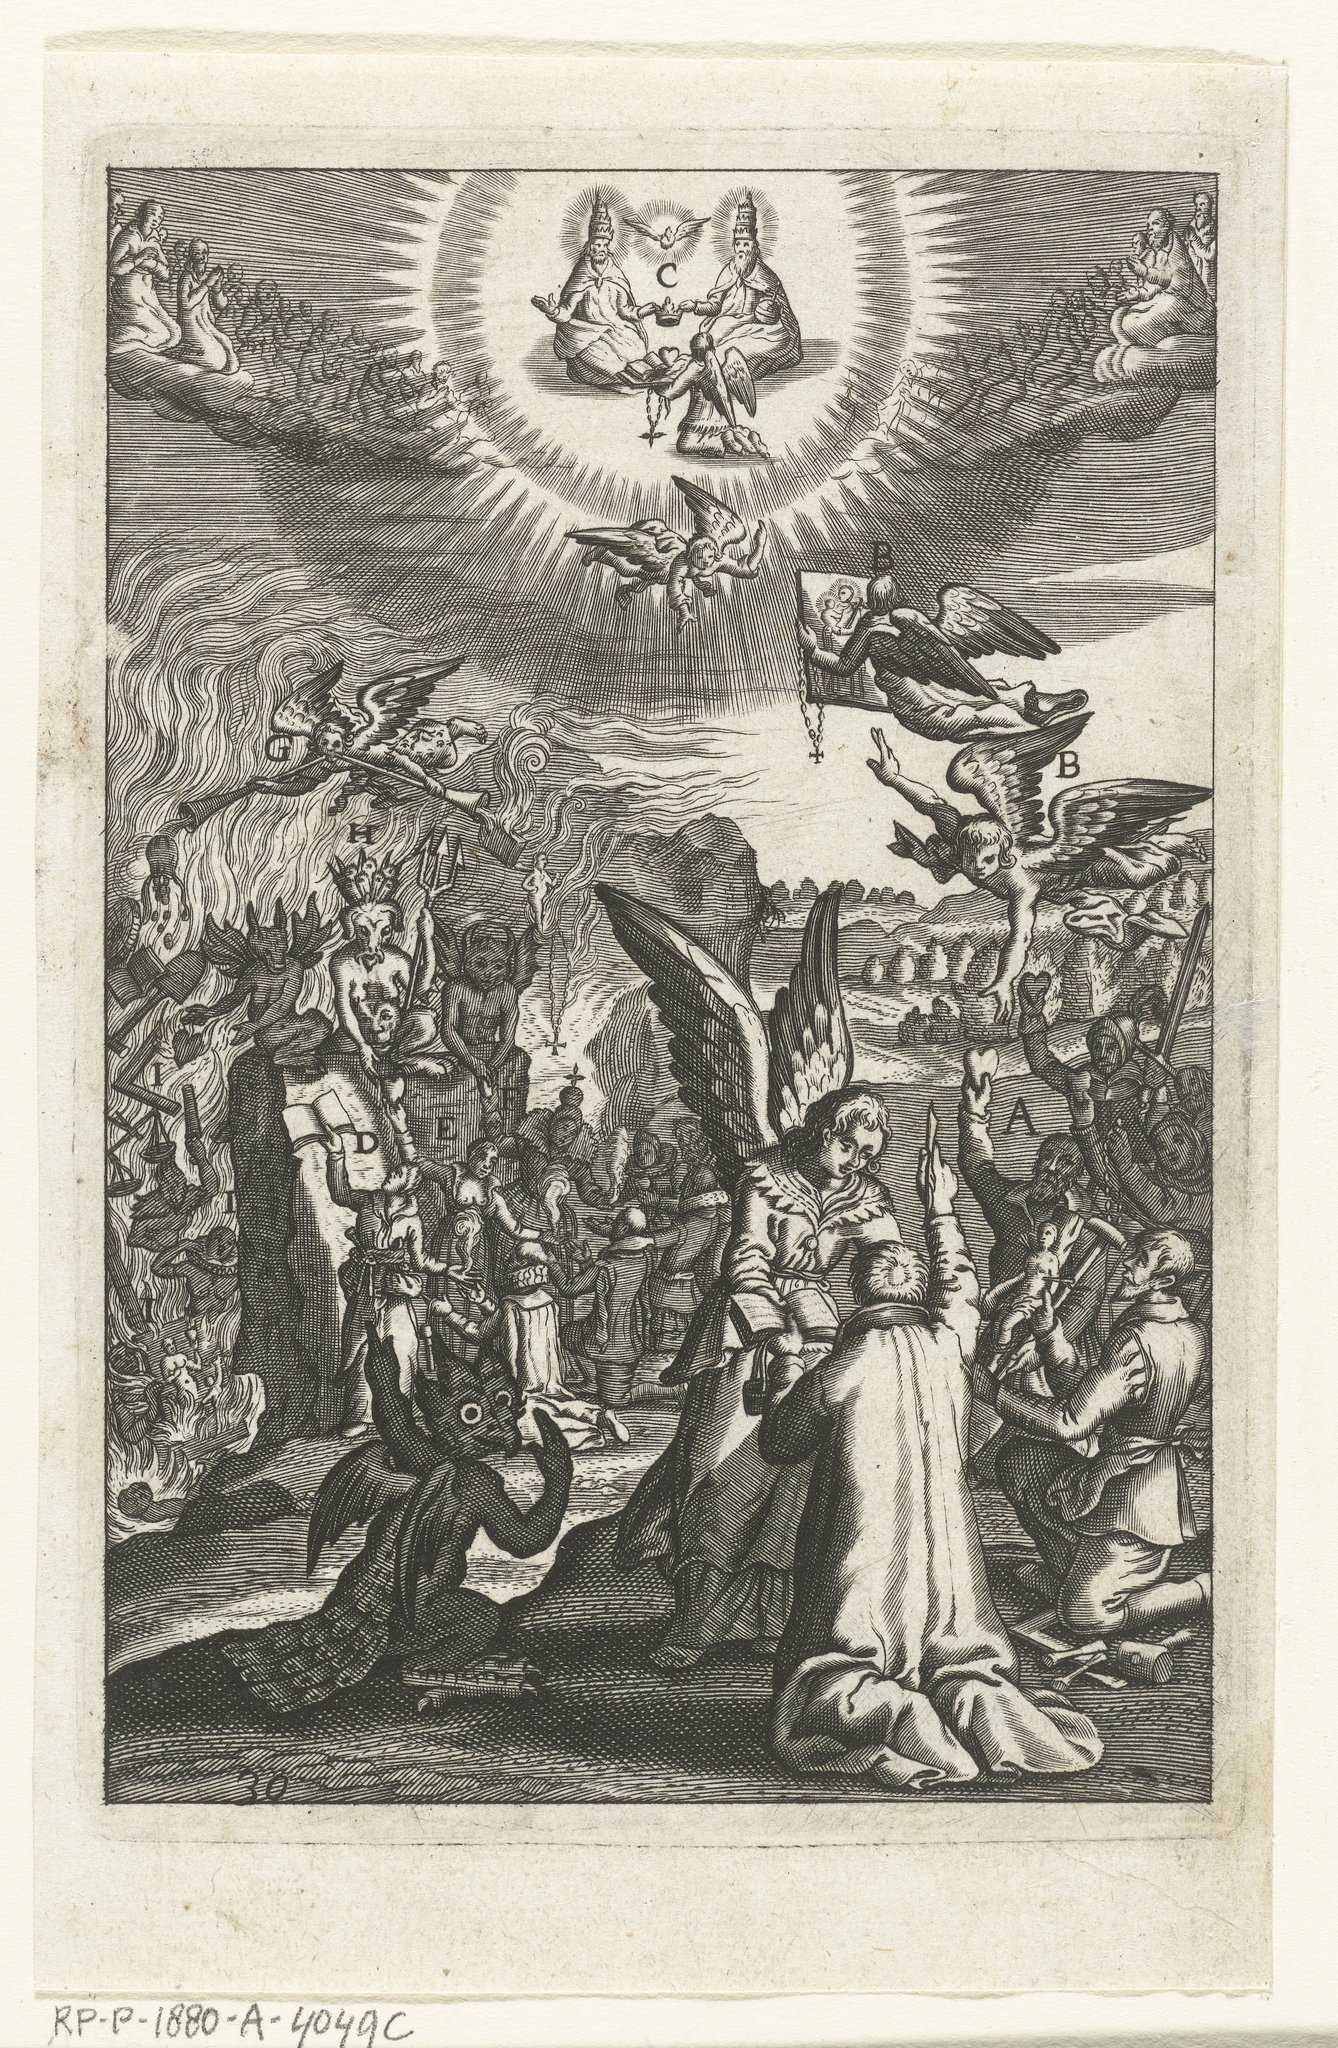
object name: book illustration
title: Den wech des eeuwich levens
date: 1620-1623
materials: paper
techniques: engraving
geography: antwerp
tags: the life of man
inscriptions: collector's mark: Lugt 2228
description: Prent uit: Antoine Sucquet, Den wech des eeuwich levens, beschreven int latijn : met beelden verlicht door Boëtius a Bolsvert, Antwerpen, Hendrick Aertssens, 1623, afb. tegenover p. 666